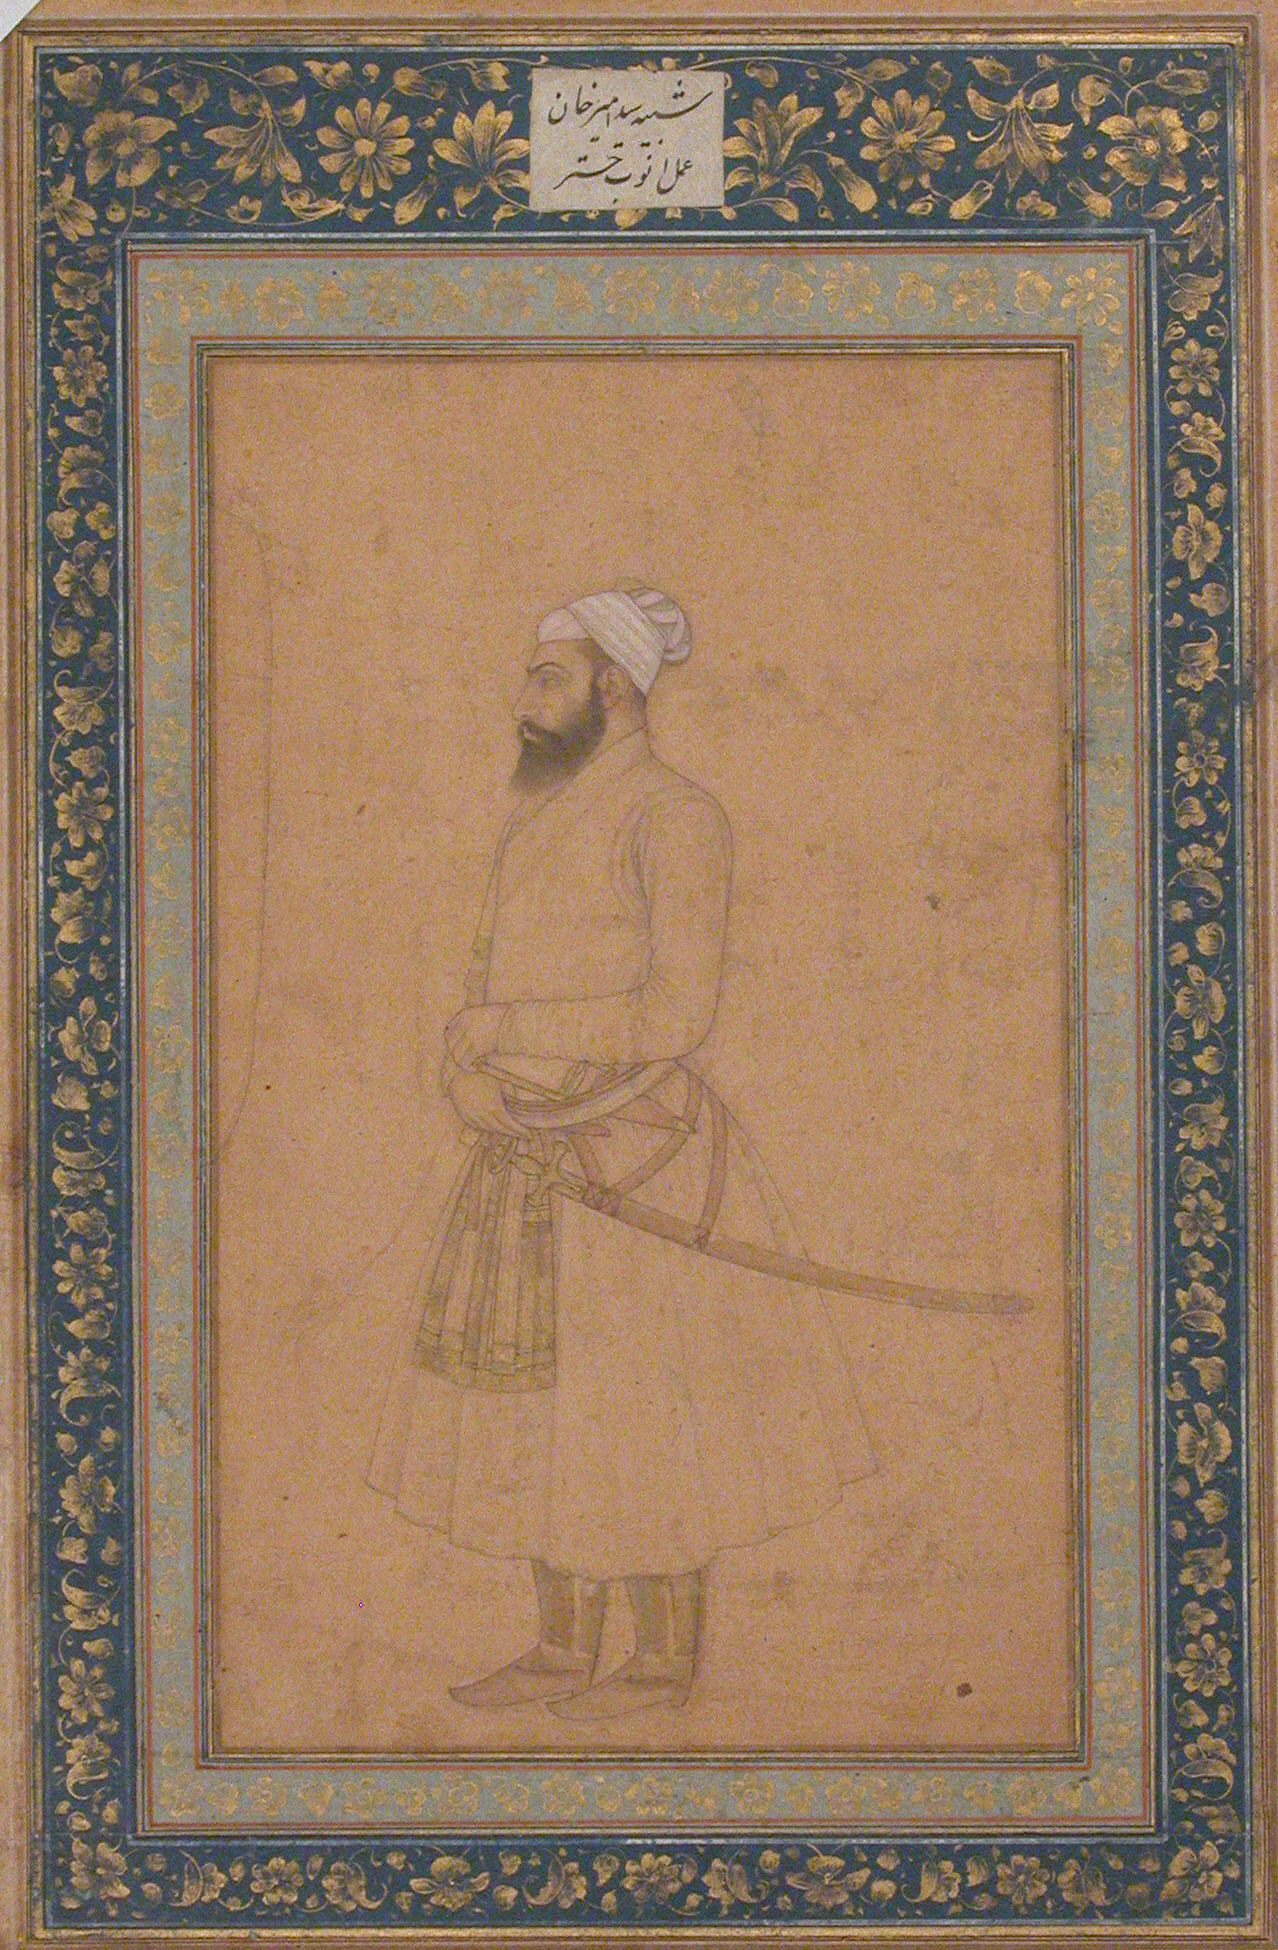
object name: illustrated album leaf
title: Portrait of Sayyid Amir Khan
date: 1651-1700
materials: gold, ink, paper, watercolor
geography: india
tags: men,profiles